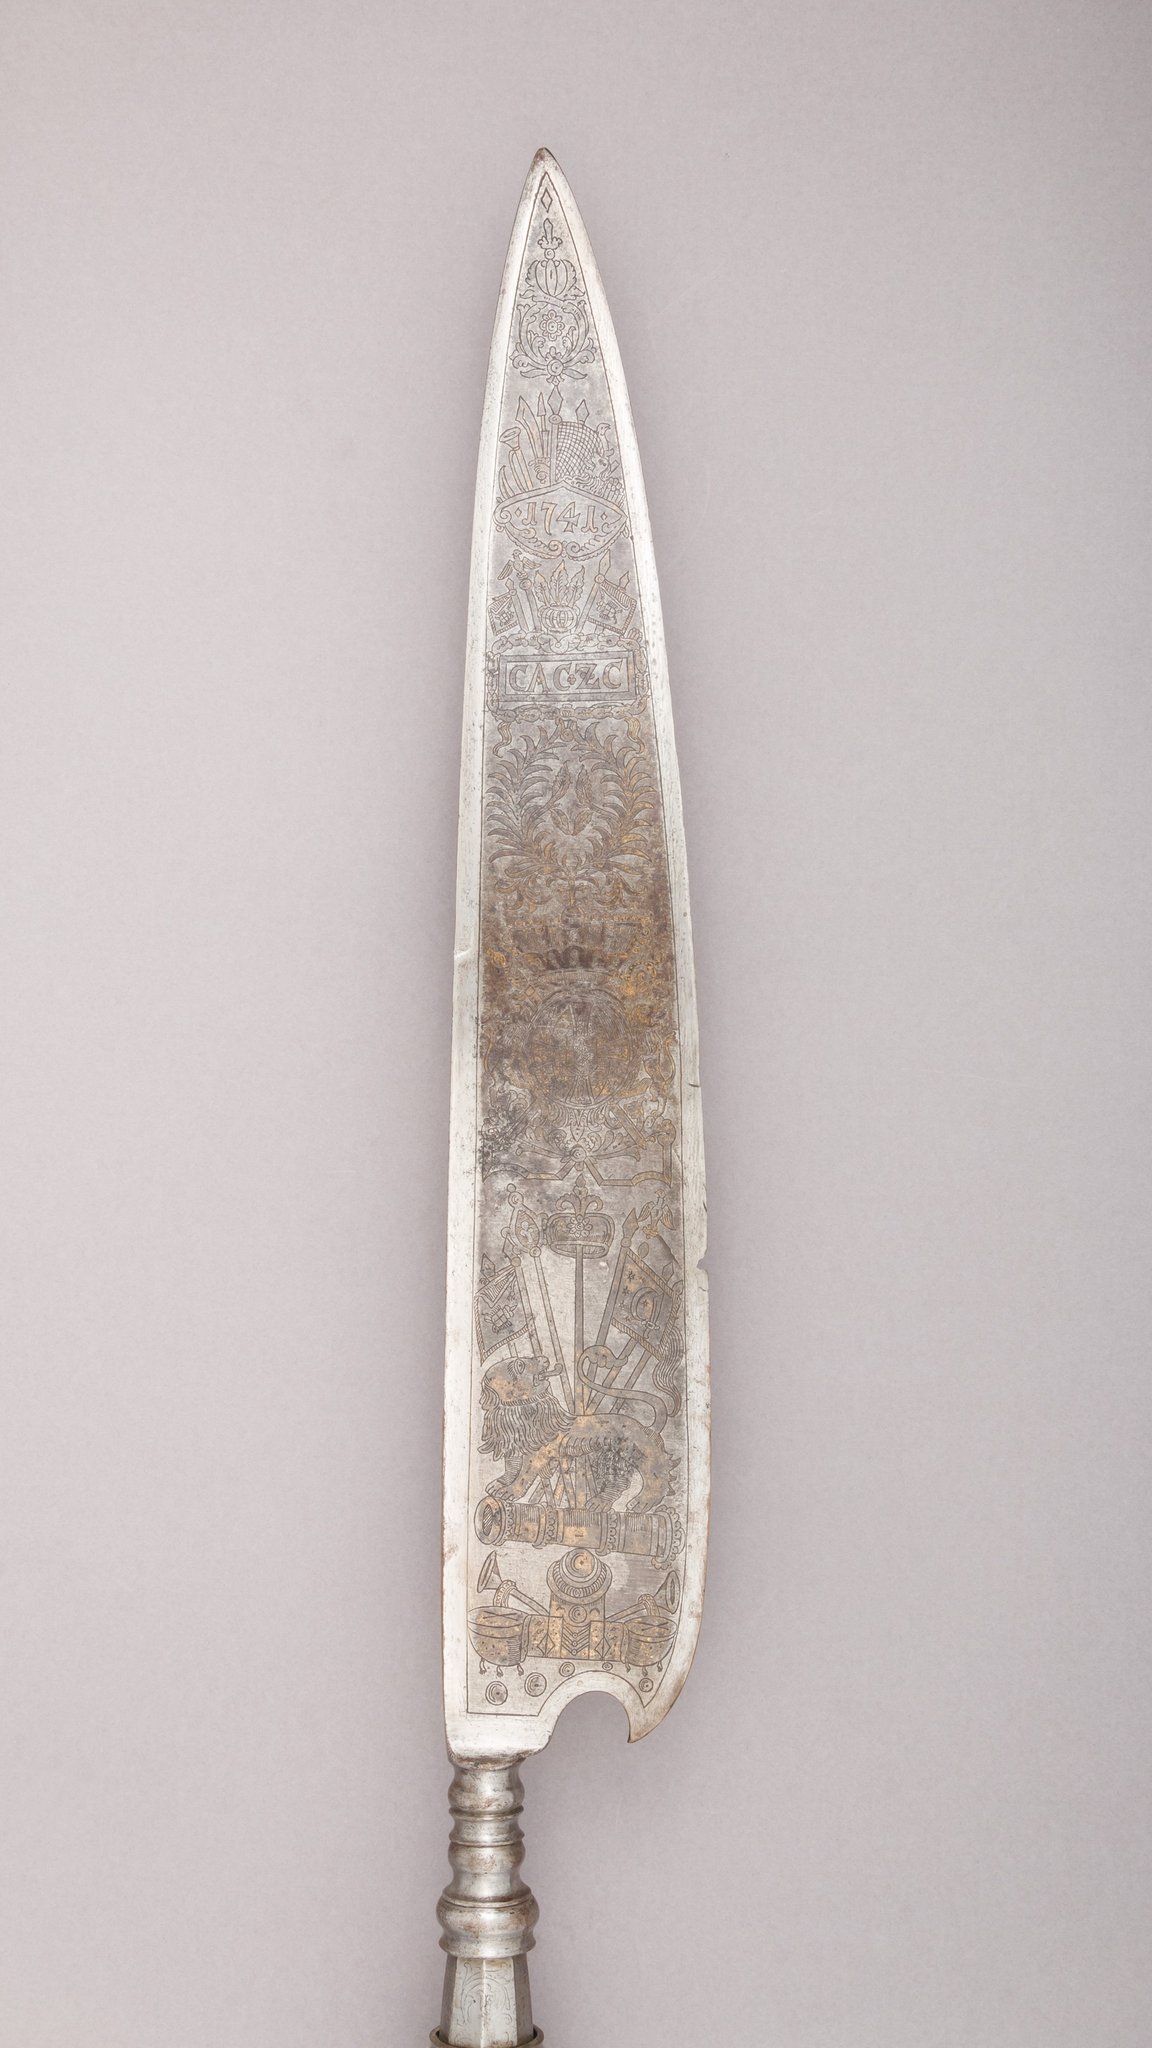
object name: cousa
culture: german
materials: gold, steel, textile, wood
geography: germany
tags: coat of arms